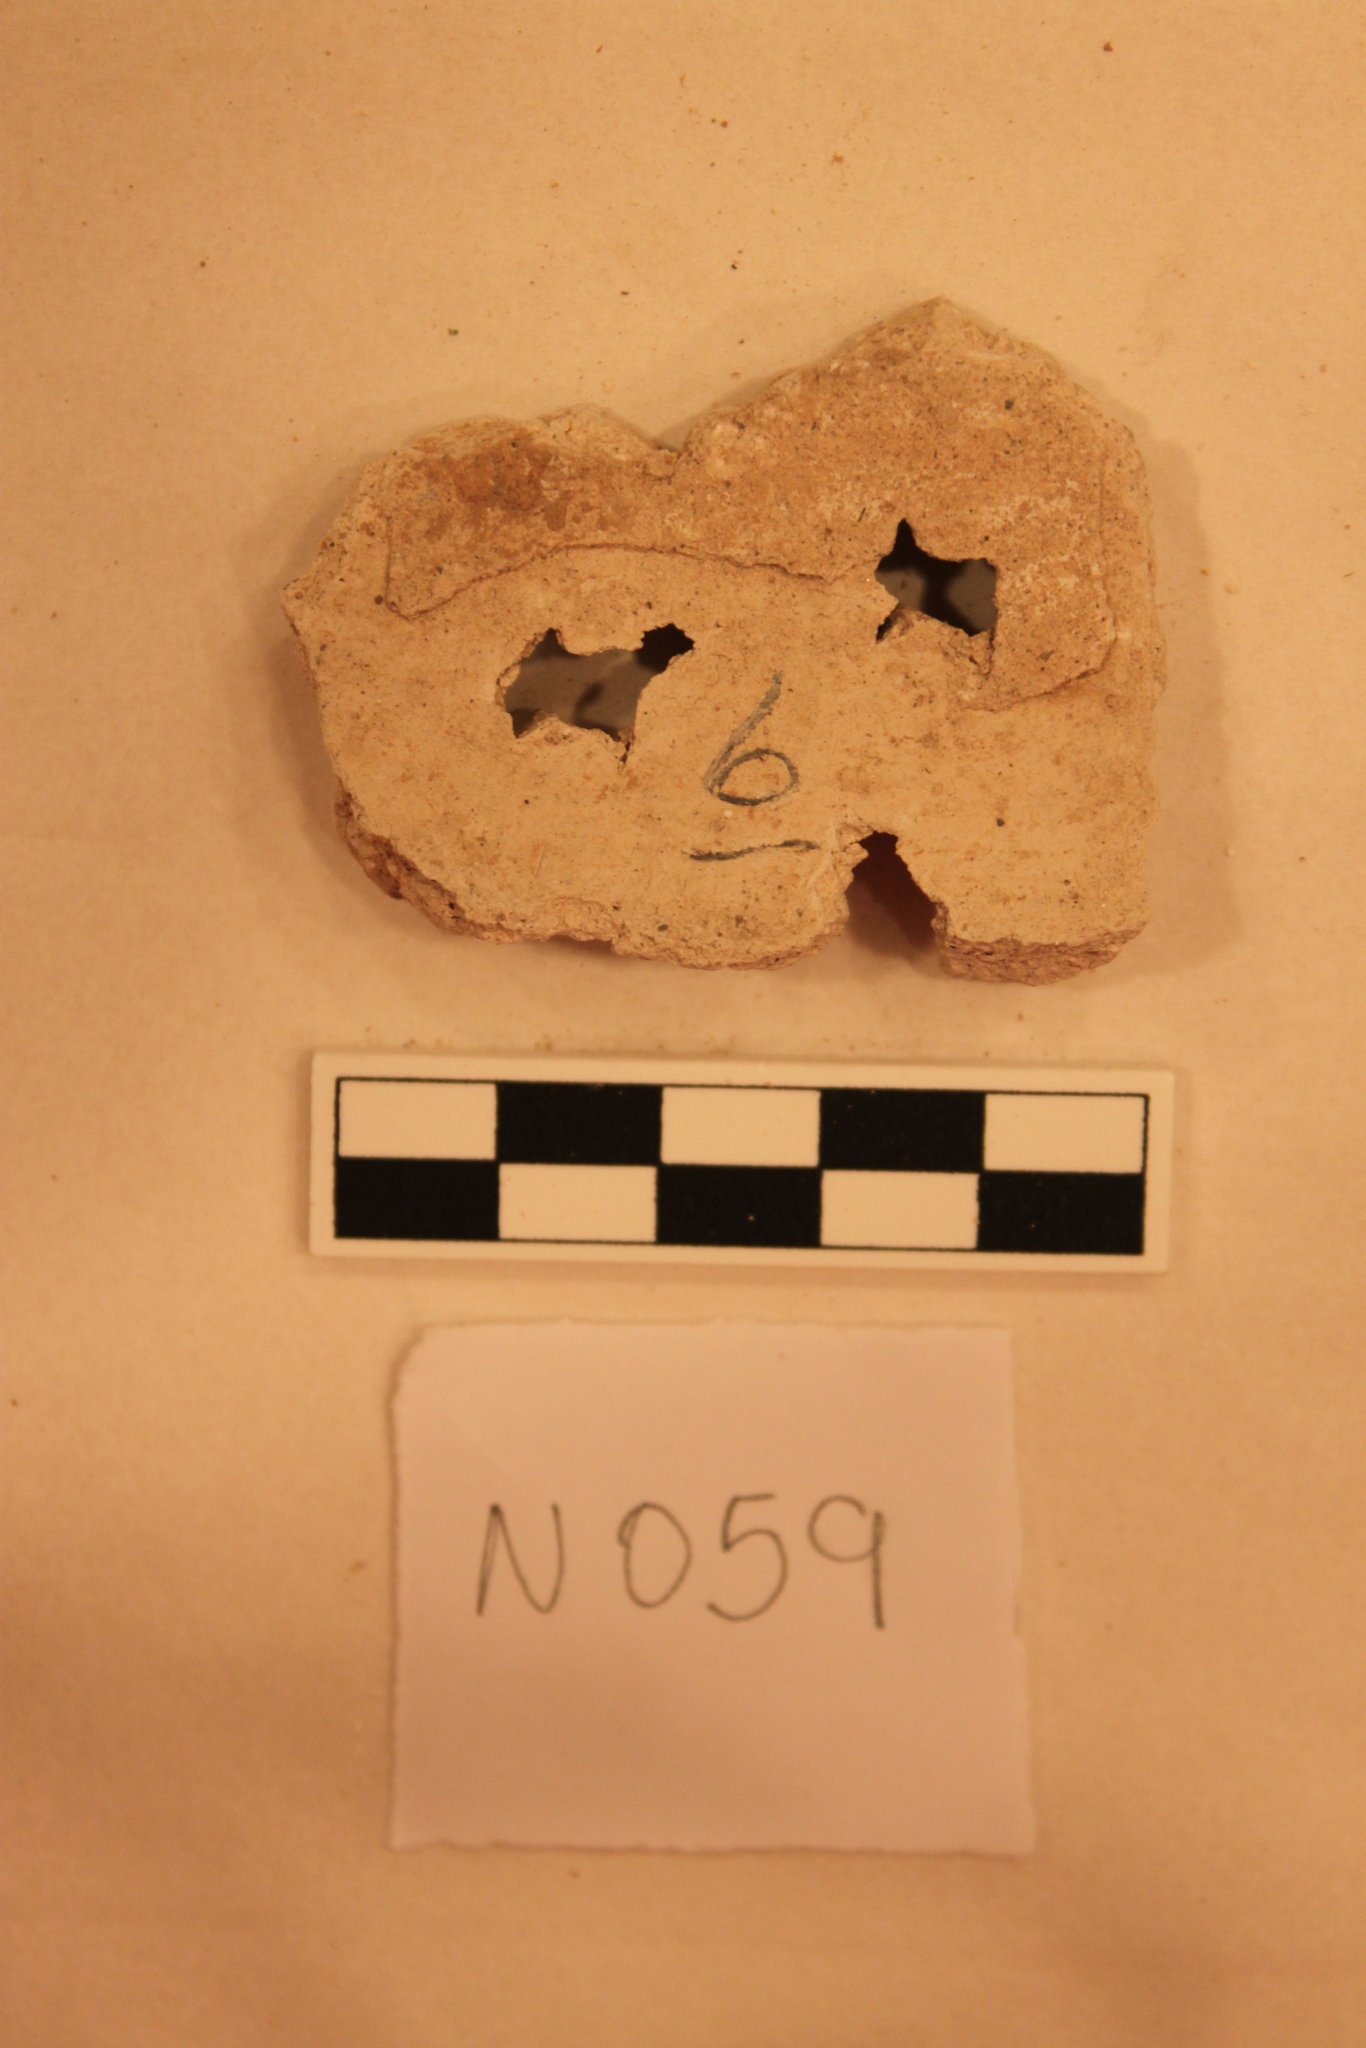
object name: fragment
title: Stucco Fragment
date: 701-1200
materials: plaster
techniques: carving, painting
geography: iran